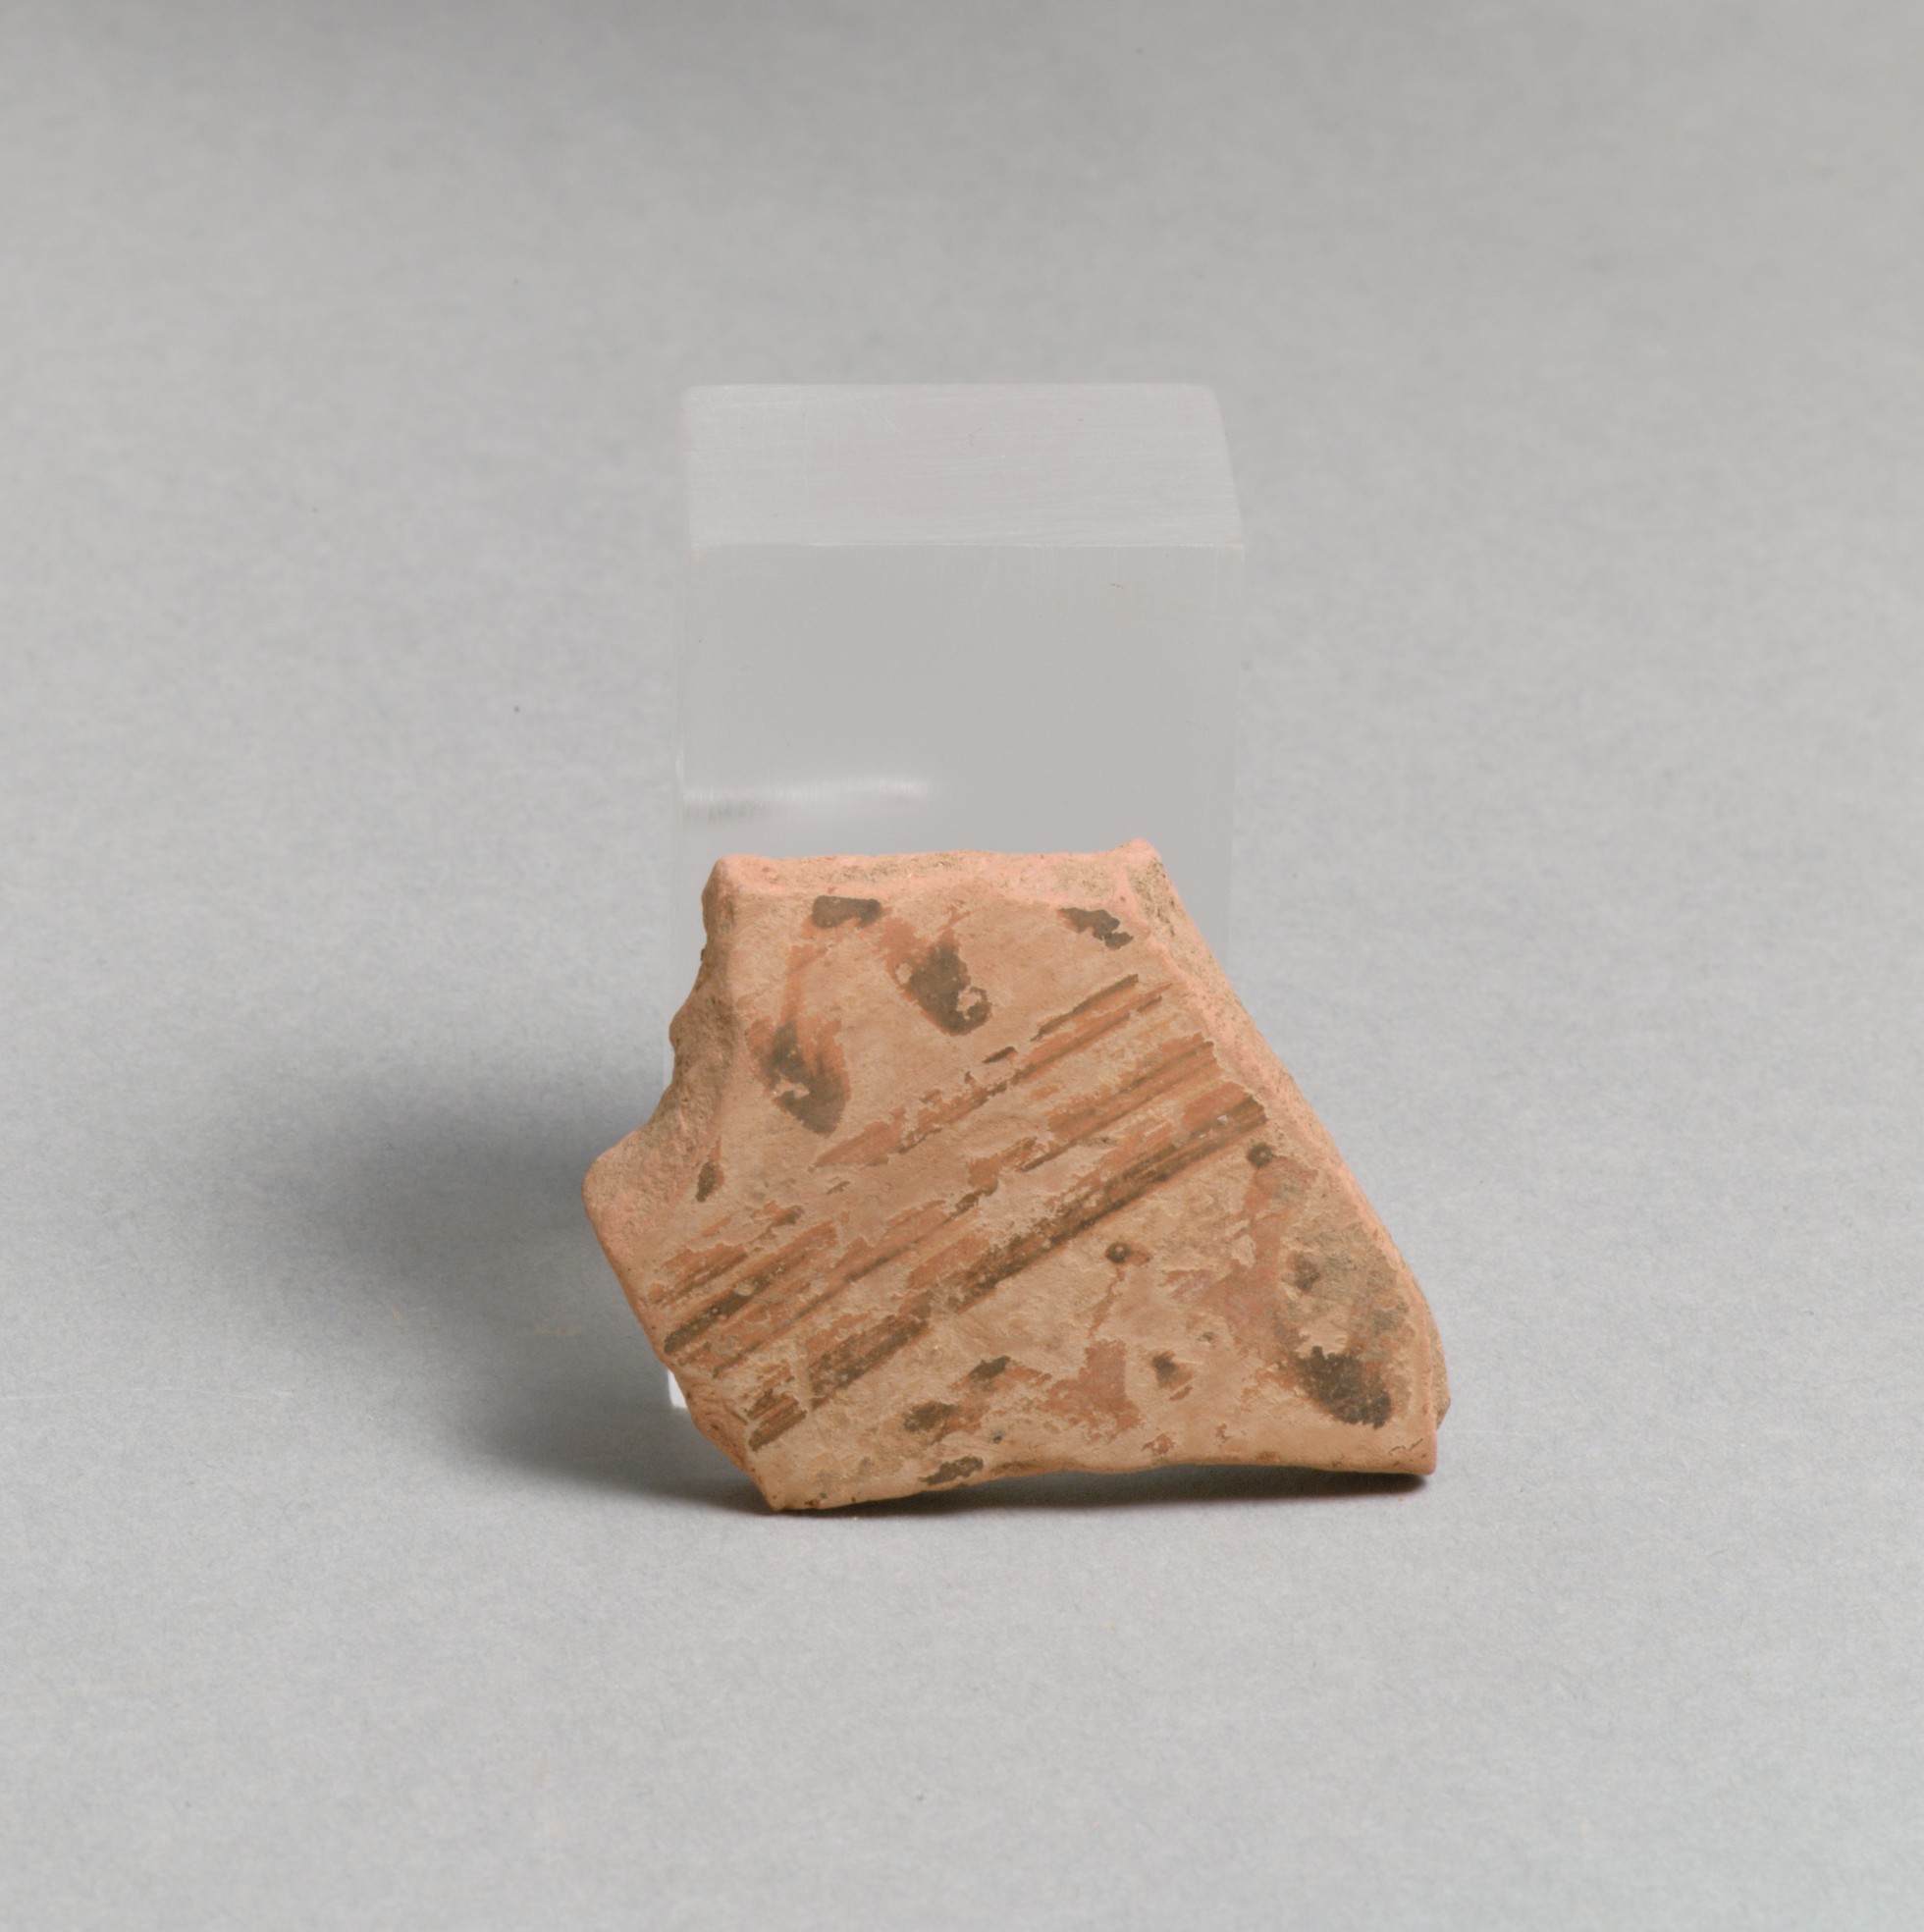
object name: vase fragment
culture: greek, laconian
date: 2000-1550 BCE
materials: terracotta